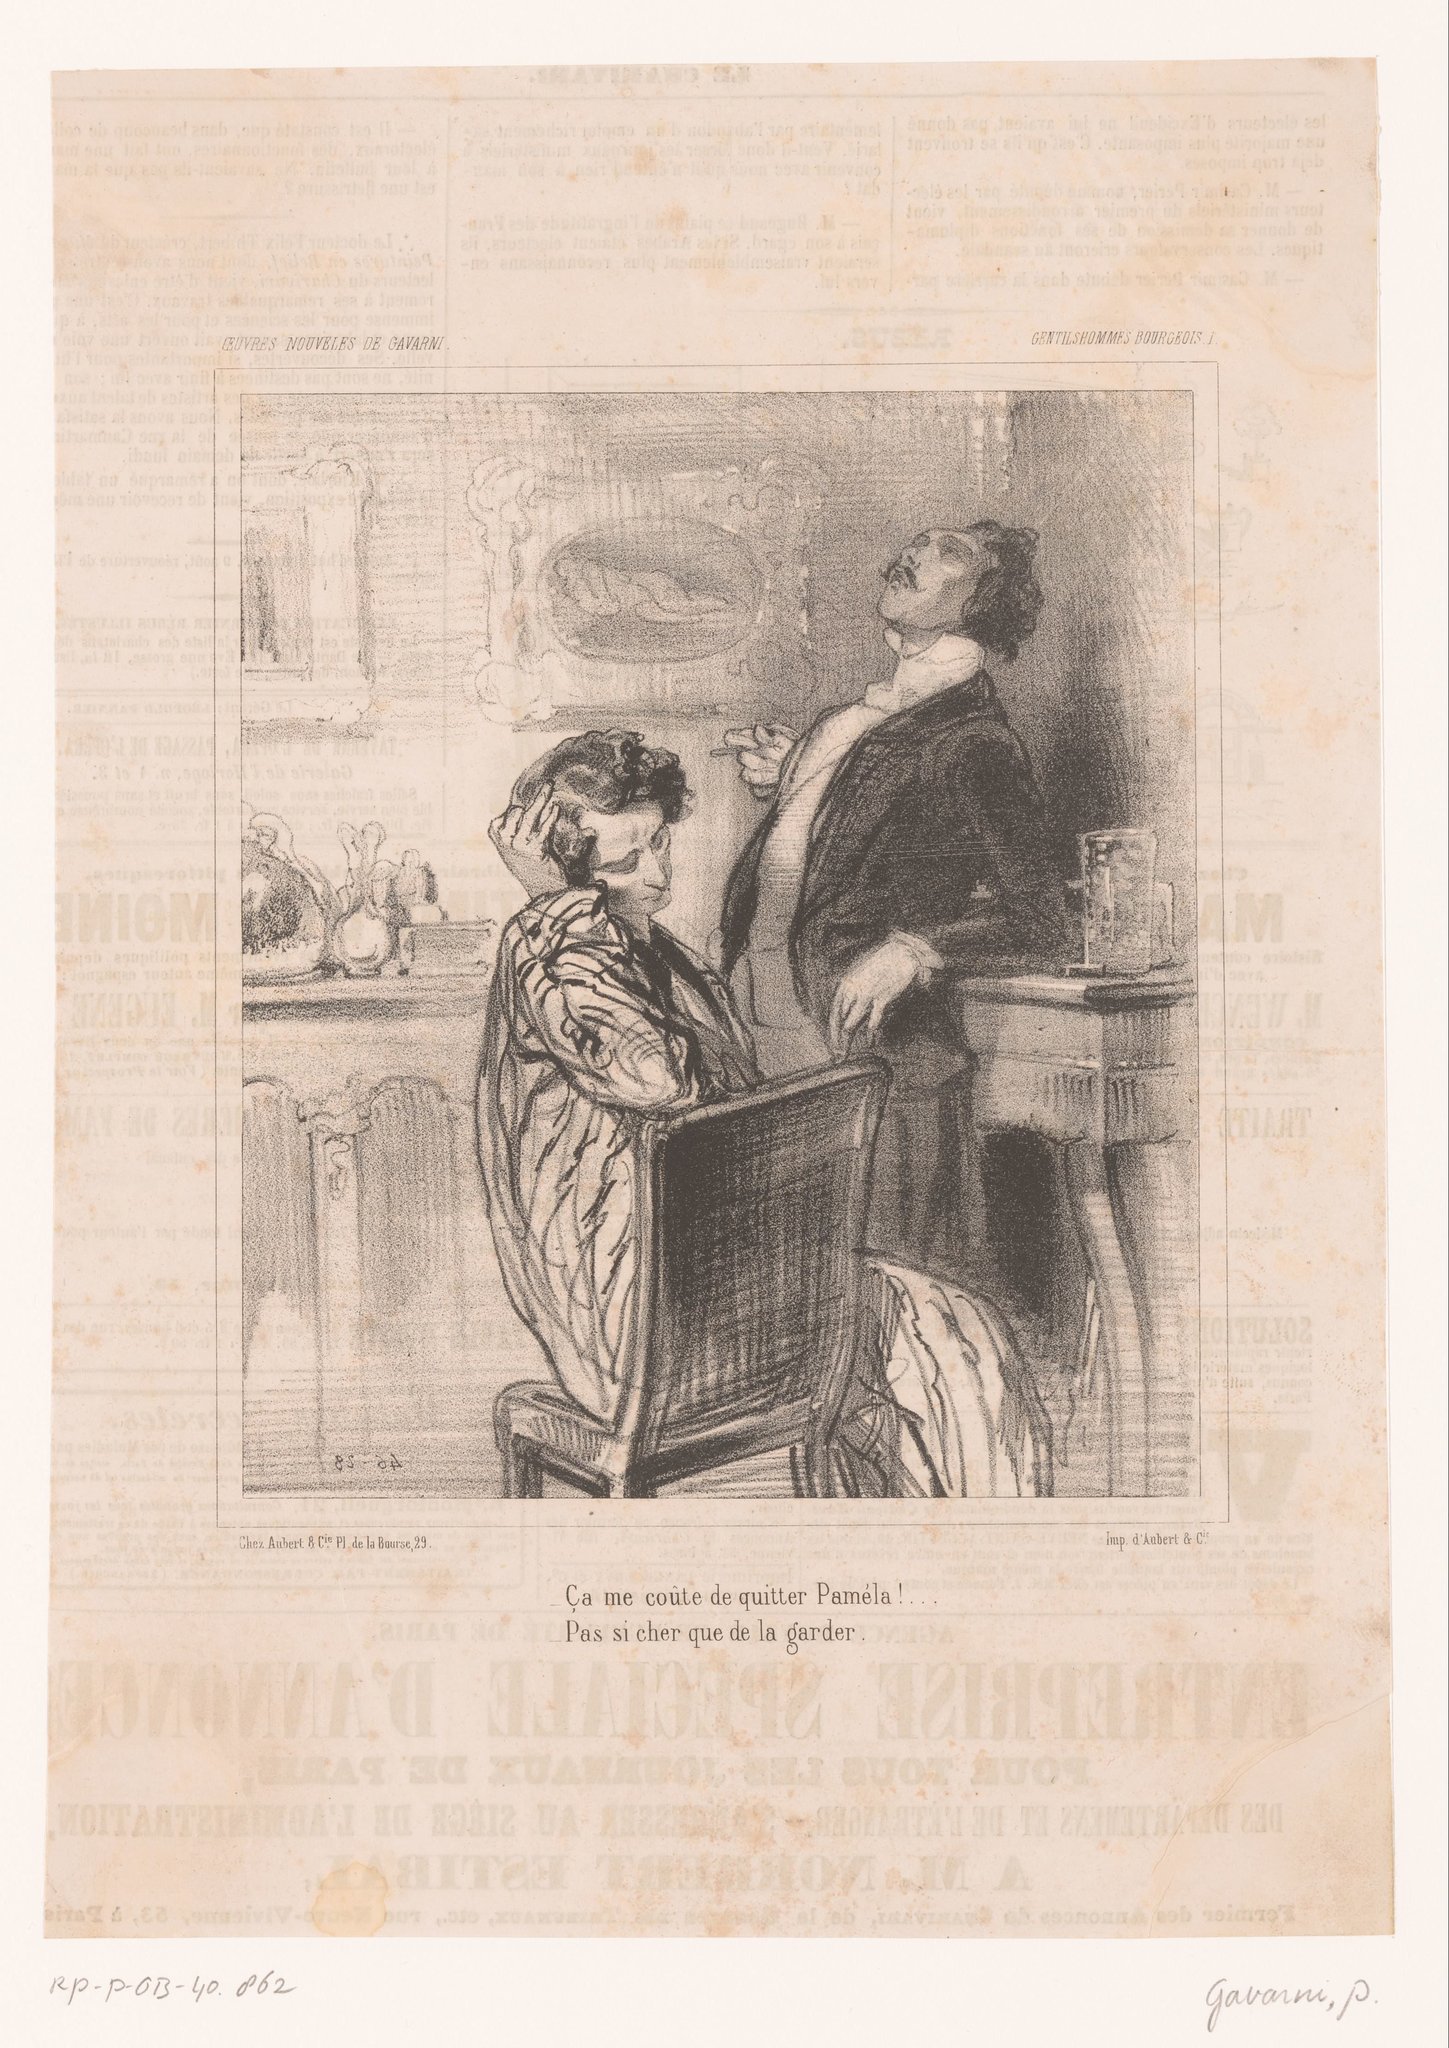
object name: print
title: Burgerlijke heren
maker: paul gavarni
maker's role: draughtsman, print maker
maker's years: 1804-1866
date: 1846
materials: paper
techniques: lithograph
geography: paris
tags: standing figure, divorce, conversation, dialogue; conversation piece, chair, sitting on an elevation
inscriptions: collector's mark: Lugt 2228a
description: De man op de stoel peinst over wat het hem zou kosten om zijn vrouw te verlaten.